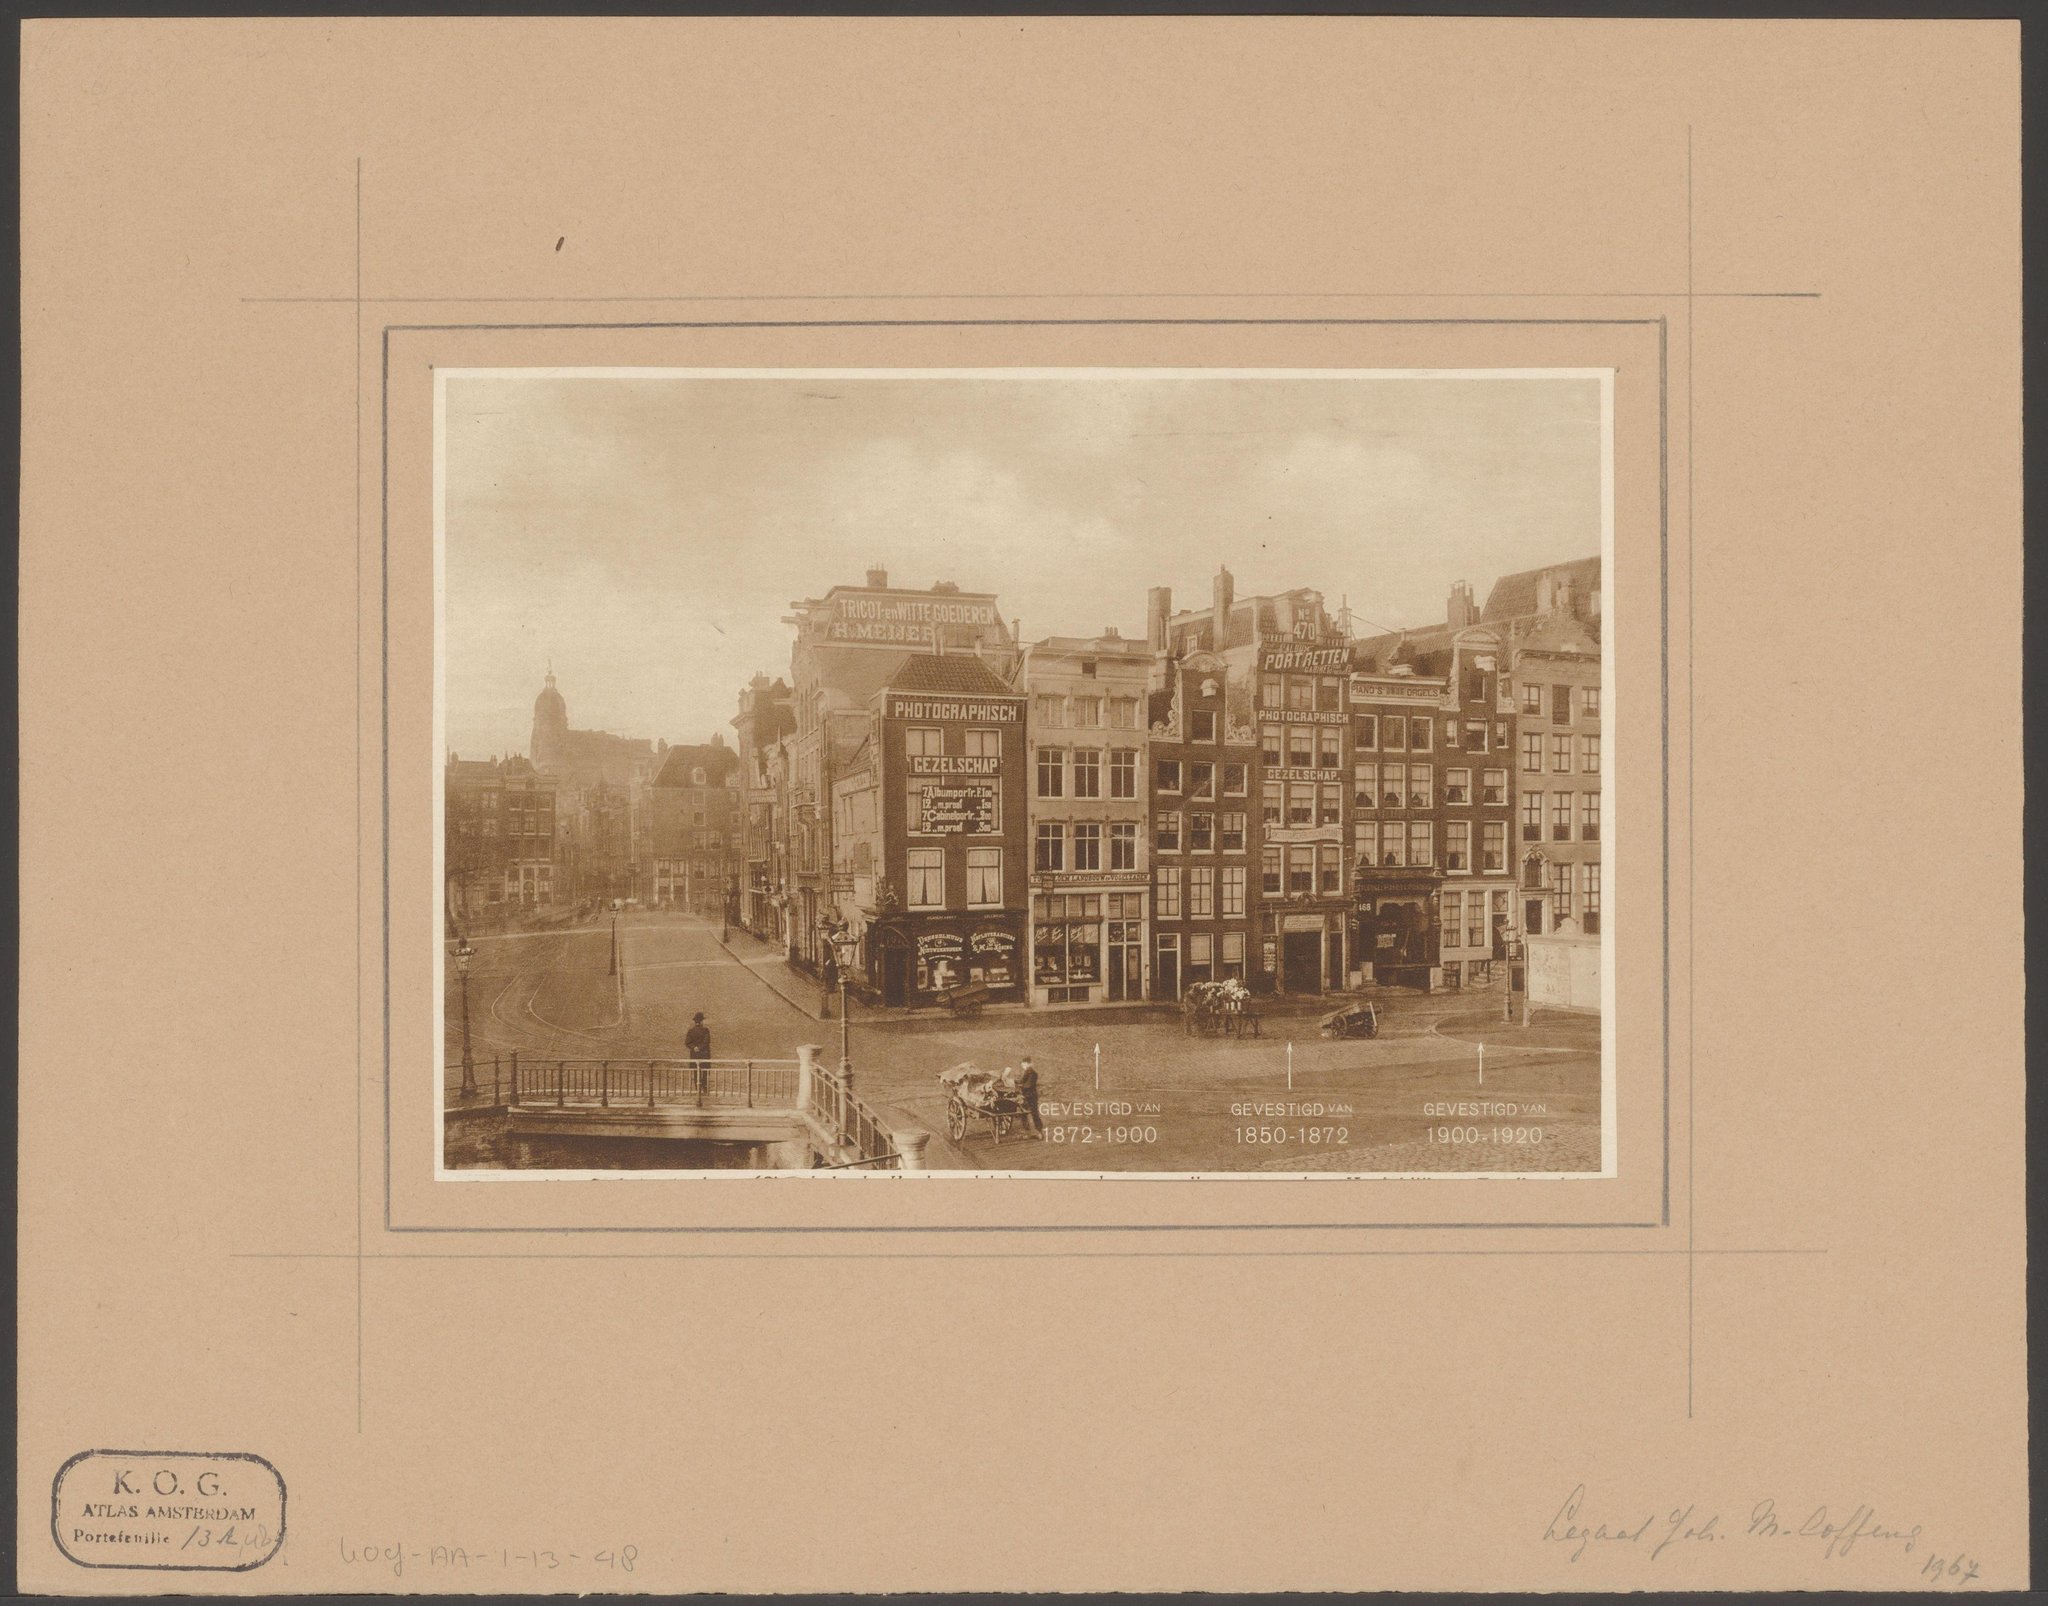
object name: photomechanical print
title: Gezicht op het Singel, hoek Koningsplein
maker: Anonymous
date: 1895-1950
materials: paper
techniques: rotogravure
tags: shop, store, square, place, circus, etc., city-view in general; 'veduta', façade (of house or building), street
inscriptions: collector's mark: ‘13A,48’ Lugt 1641b, inscription: ‘Legaat Joh. M. Coffeng / 1967’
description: Onderwerpsrubriek binnen de Atlas Amsterdam: Oude Schans, Schoutensteeg, Singel (Korte), Singel.